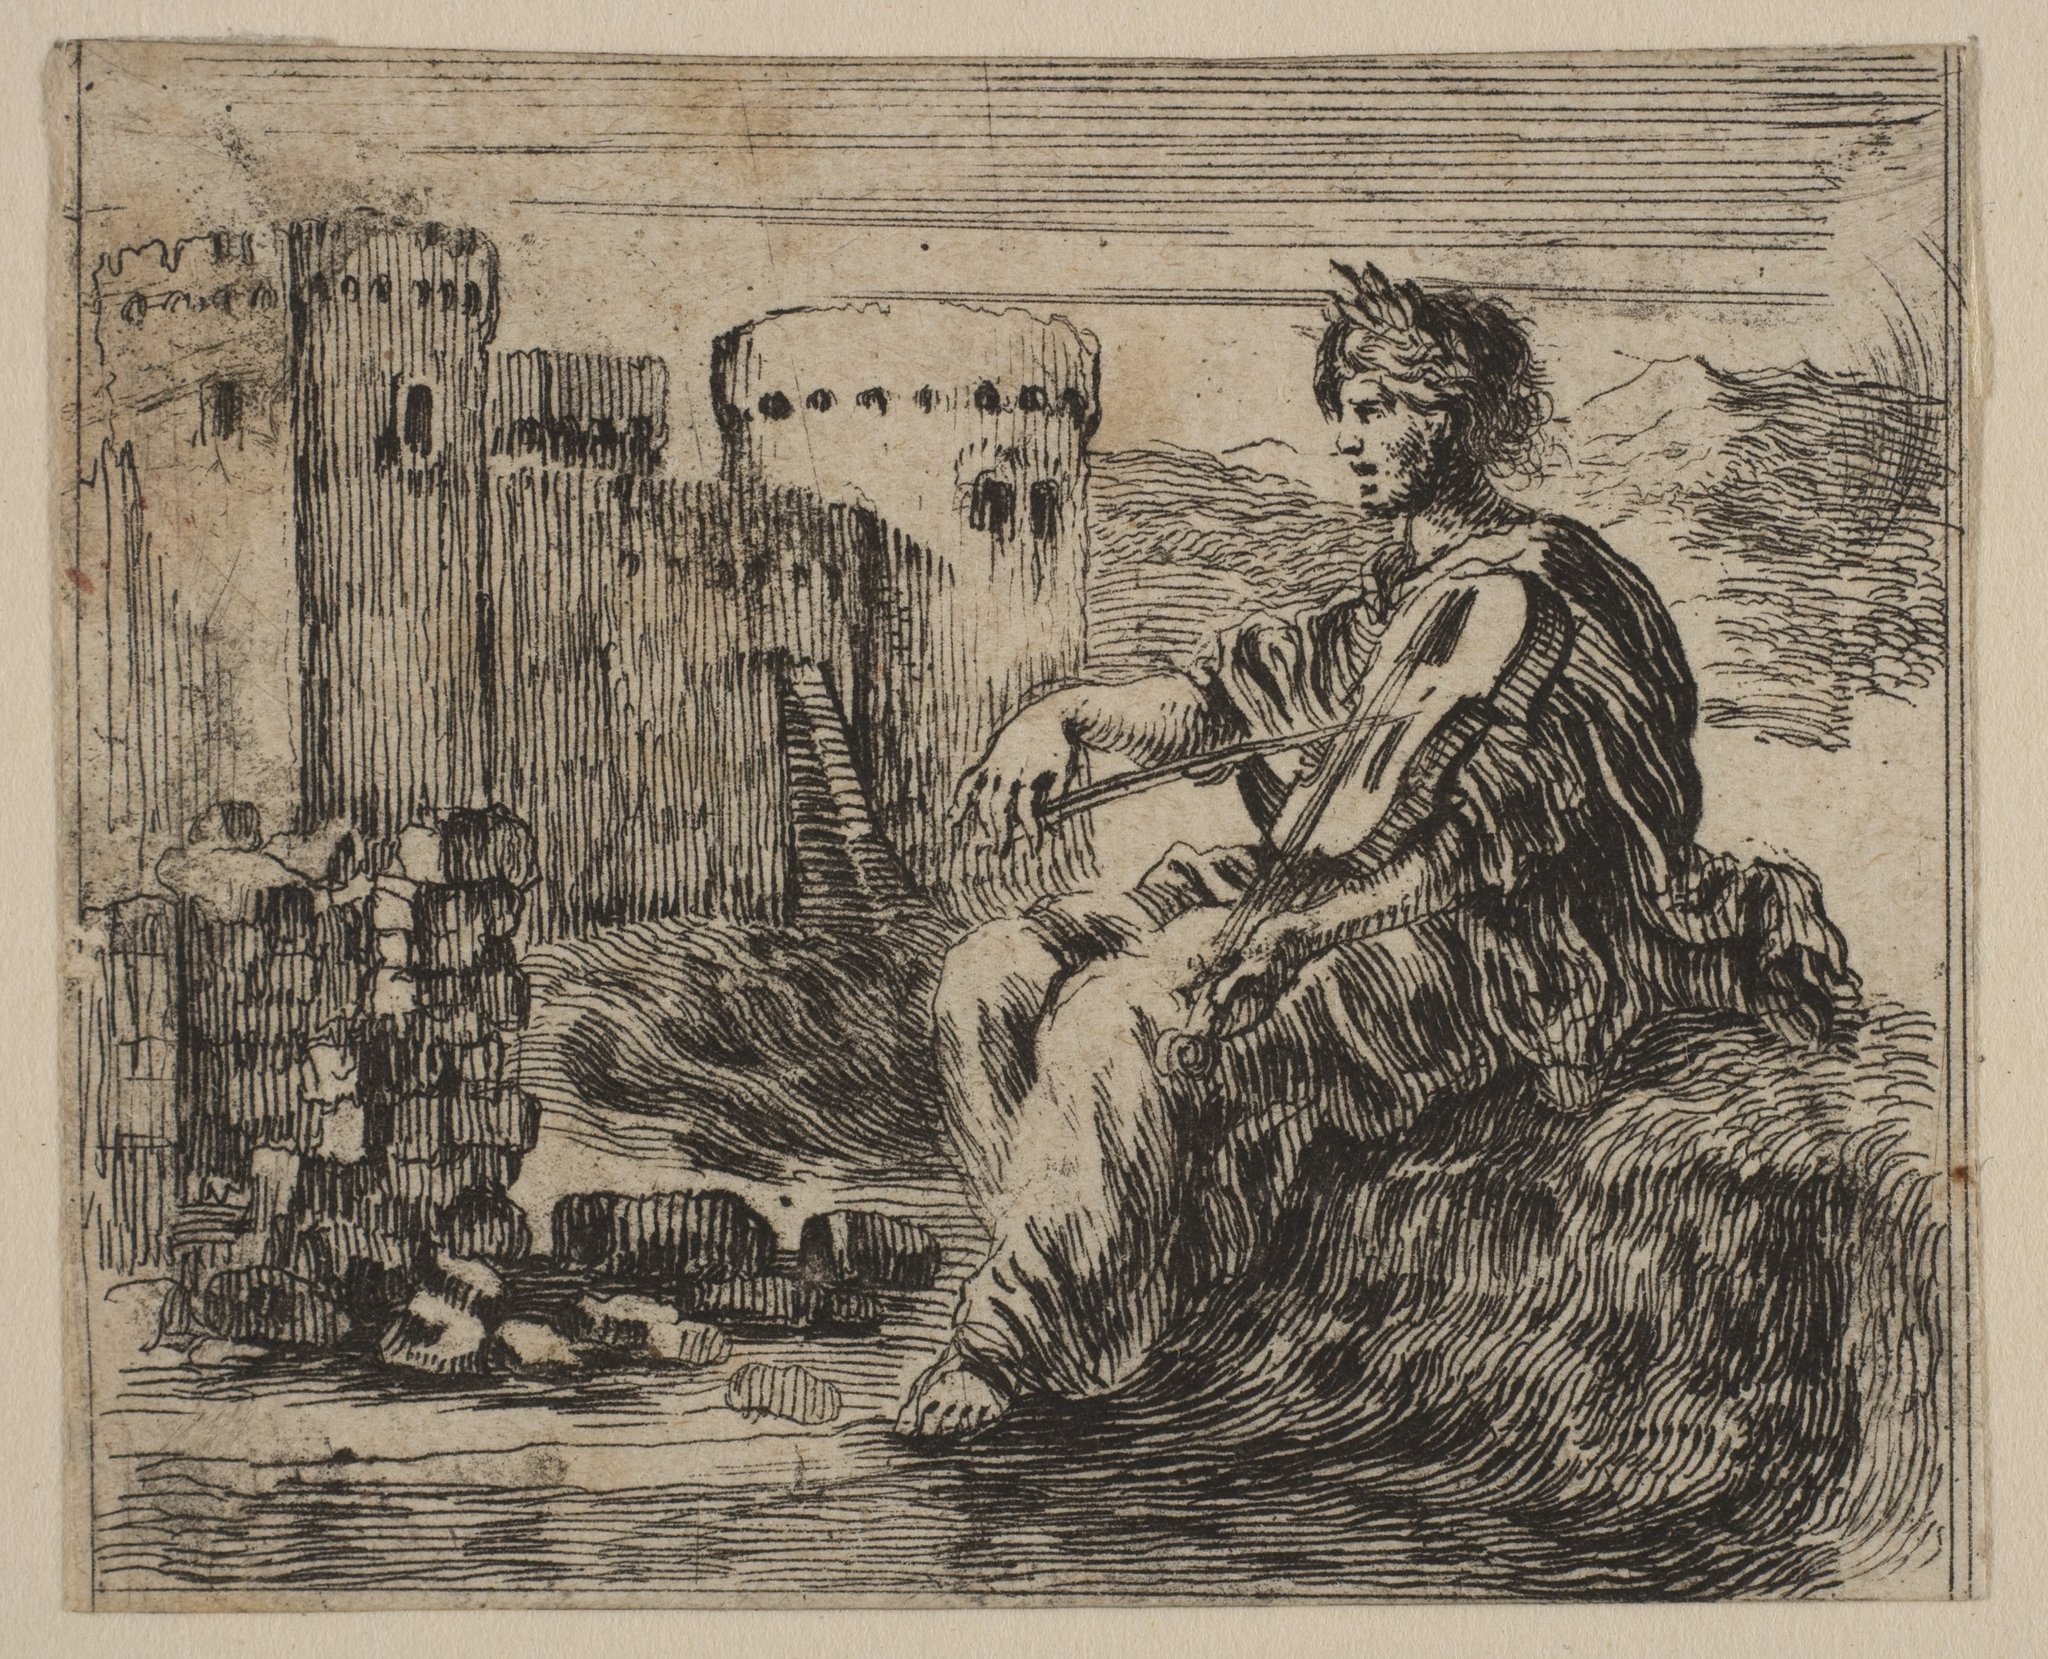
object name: print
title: Amphion, from 'Game of Mythology' (Jeu de la Mythologie)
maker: stefano della bella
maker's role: artist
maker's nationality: italian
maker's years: 1610-1664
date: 1644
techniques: etching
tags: castles,men,violins